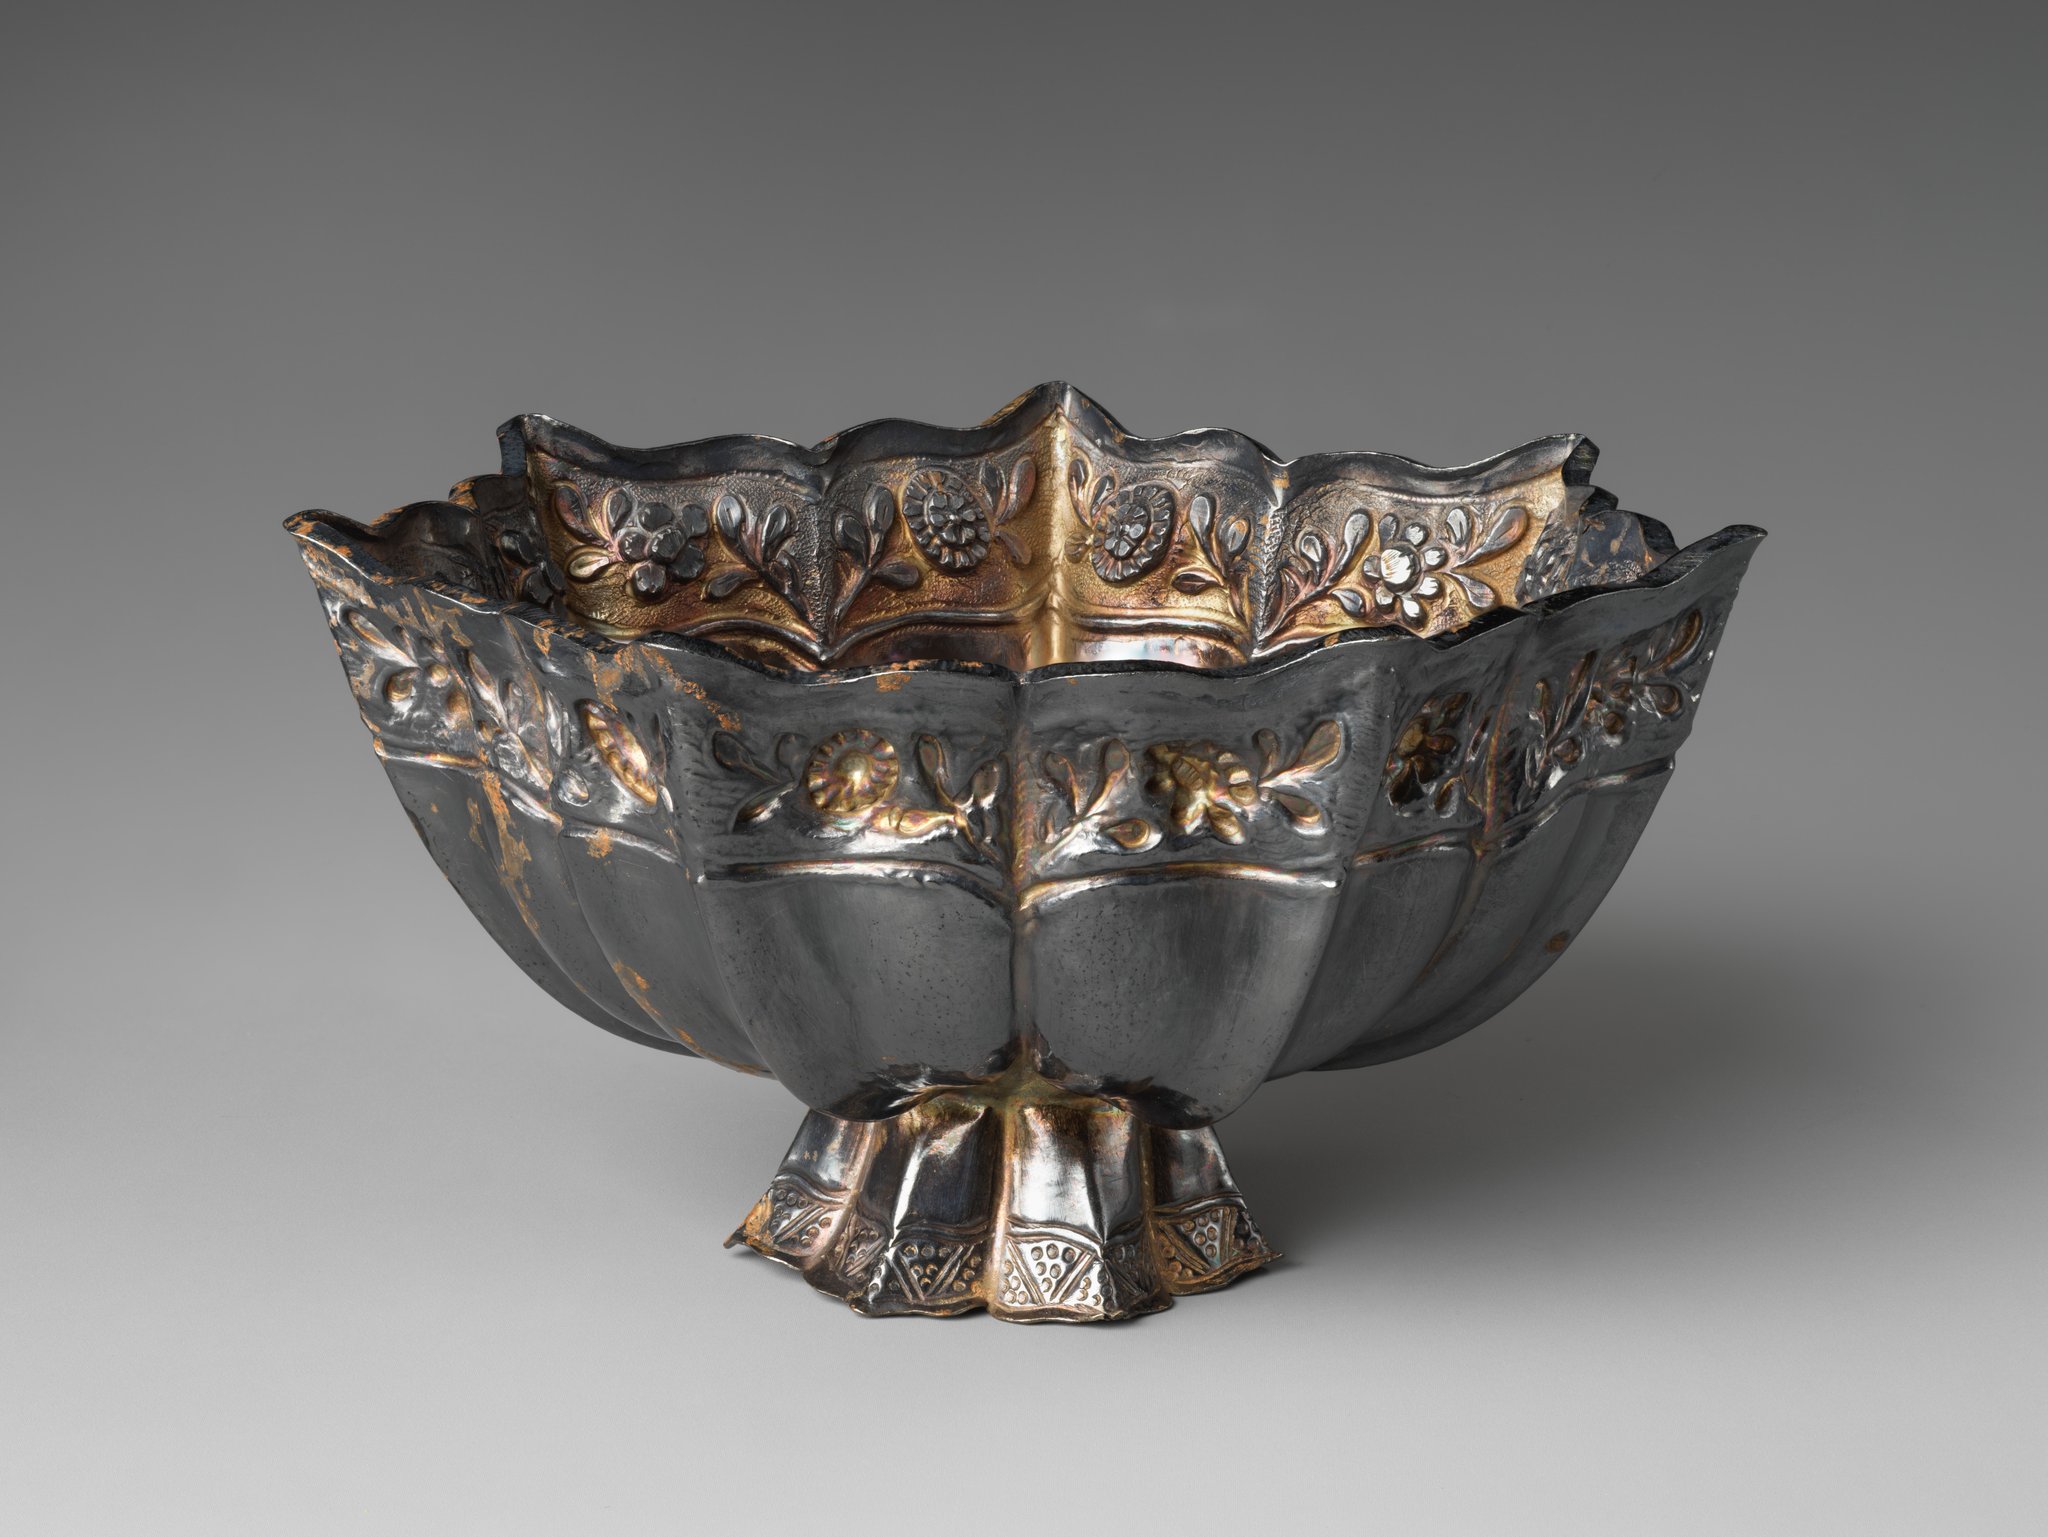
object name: cup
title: Foliated cup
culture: chinese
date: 1201-1300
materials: silver